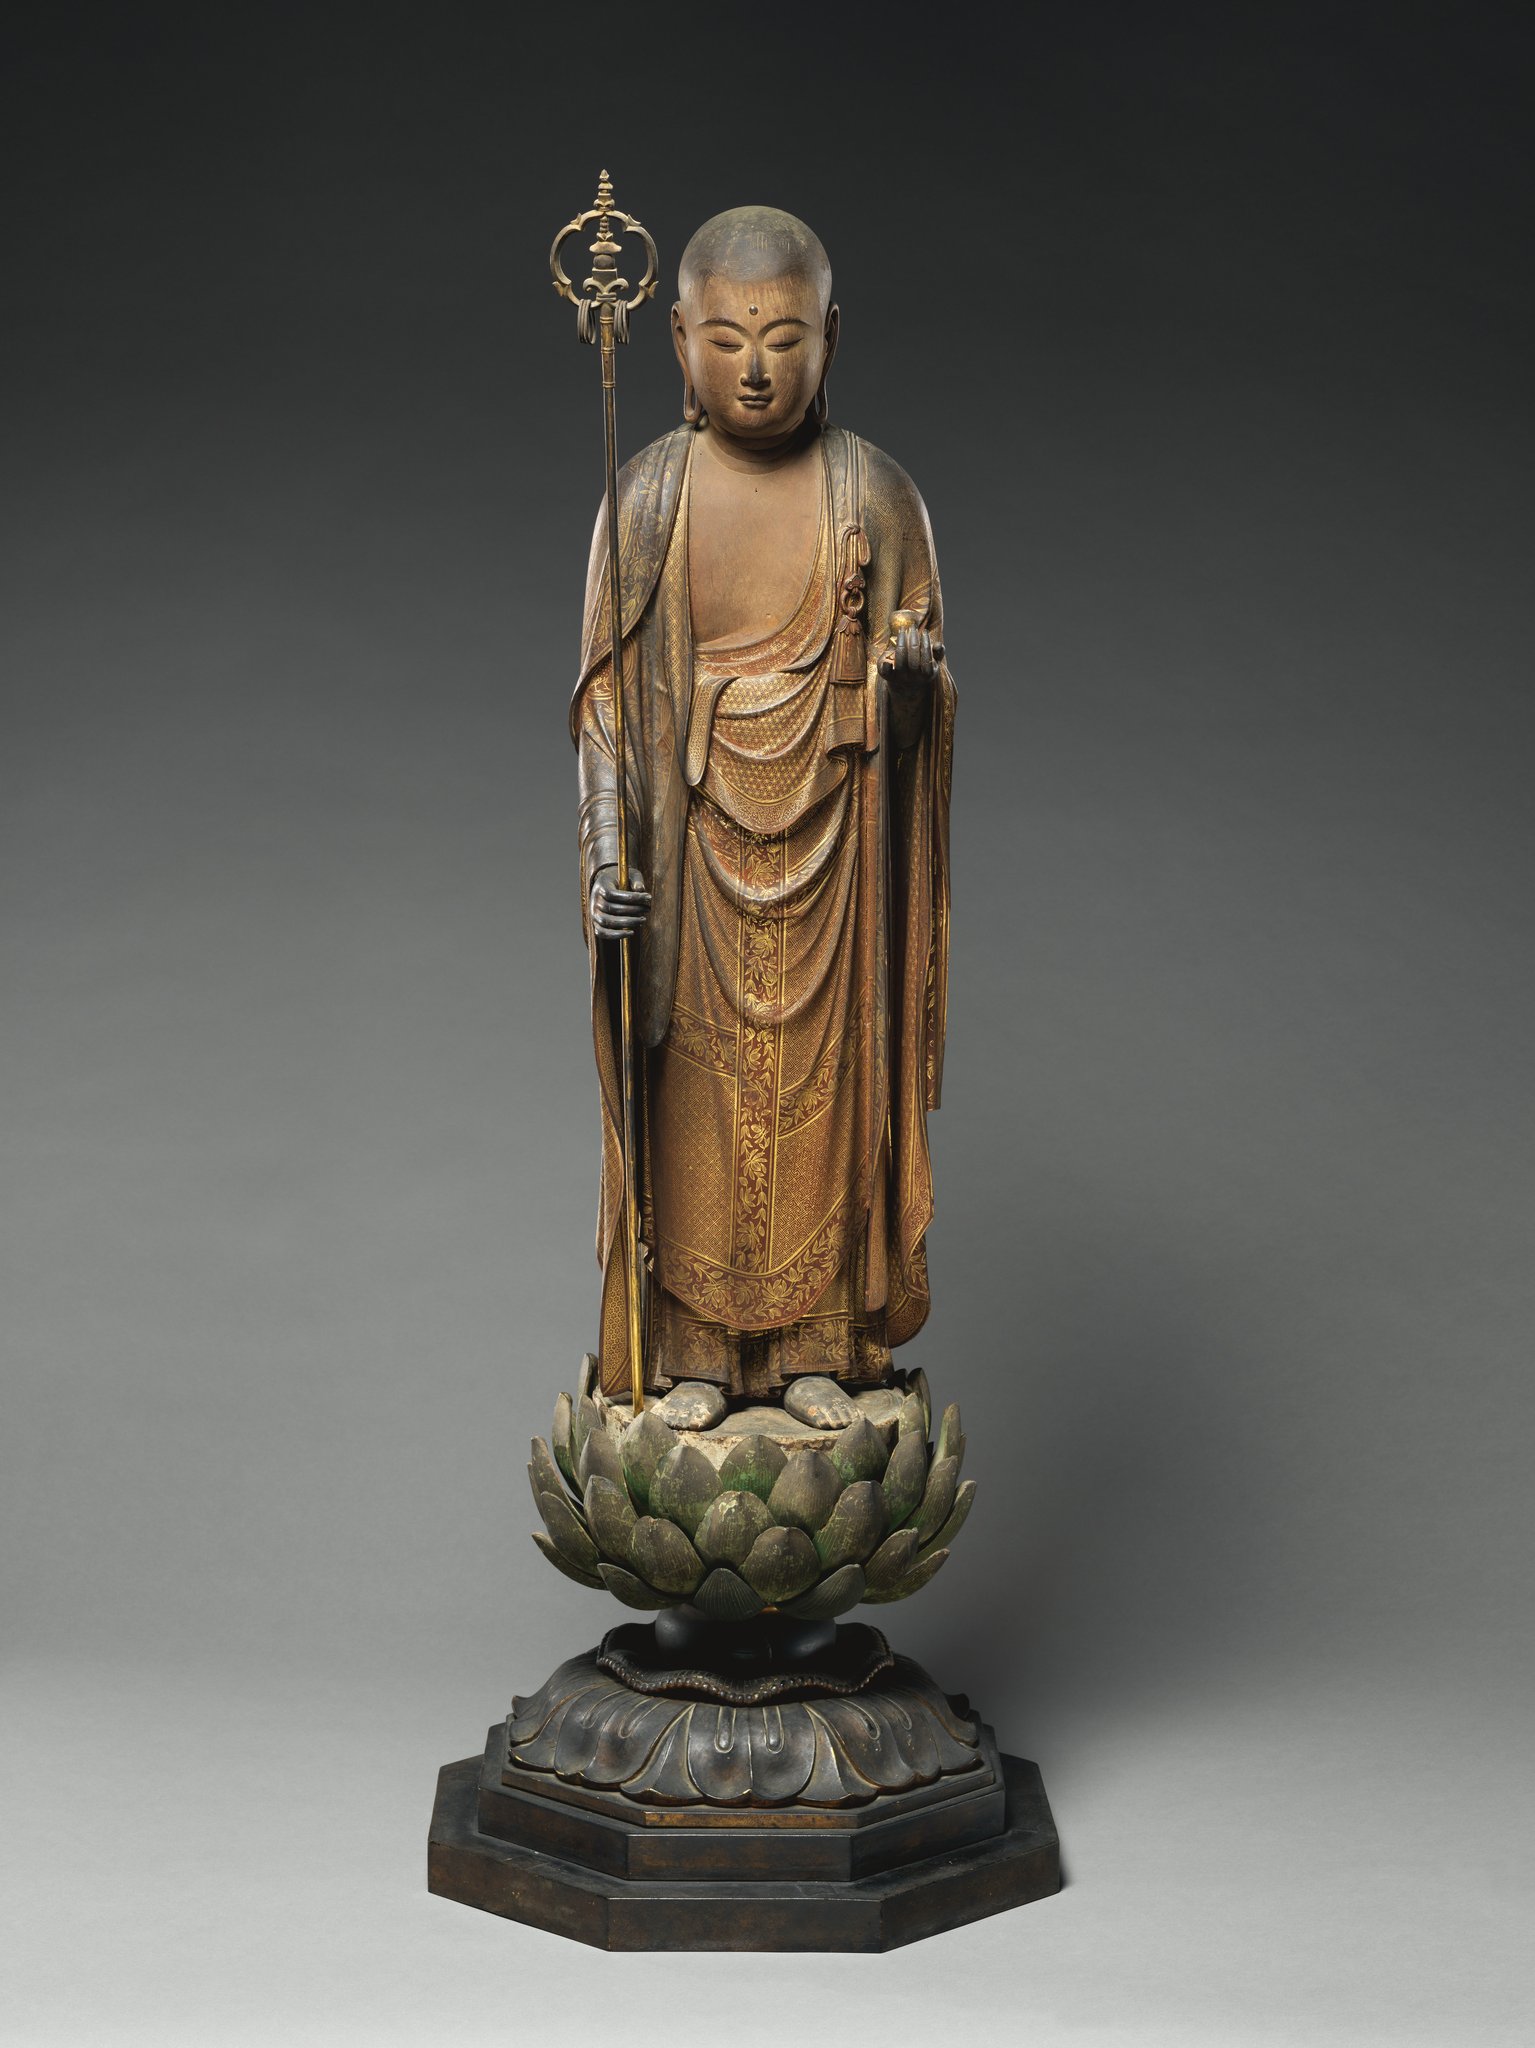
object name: statue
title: The Bodhisattva Jizō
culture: japanese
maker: intan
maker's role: artist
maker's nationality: japanese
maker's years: 1200-1299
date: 1291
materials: wood, gold leaf, gold paint, pigment, quartz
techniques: cutting, kirikane, polychrome